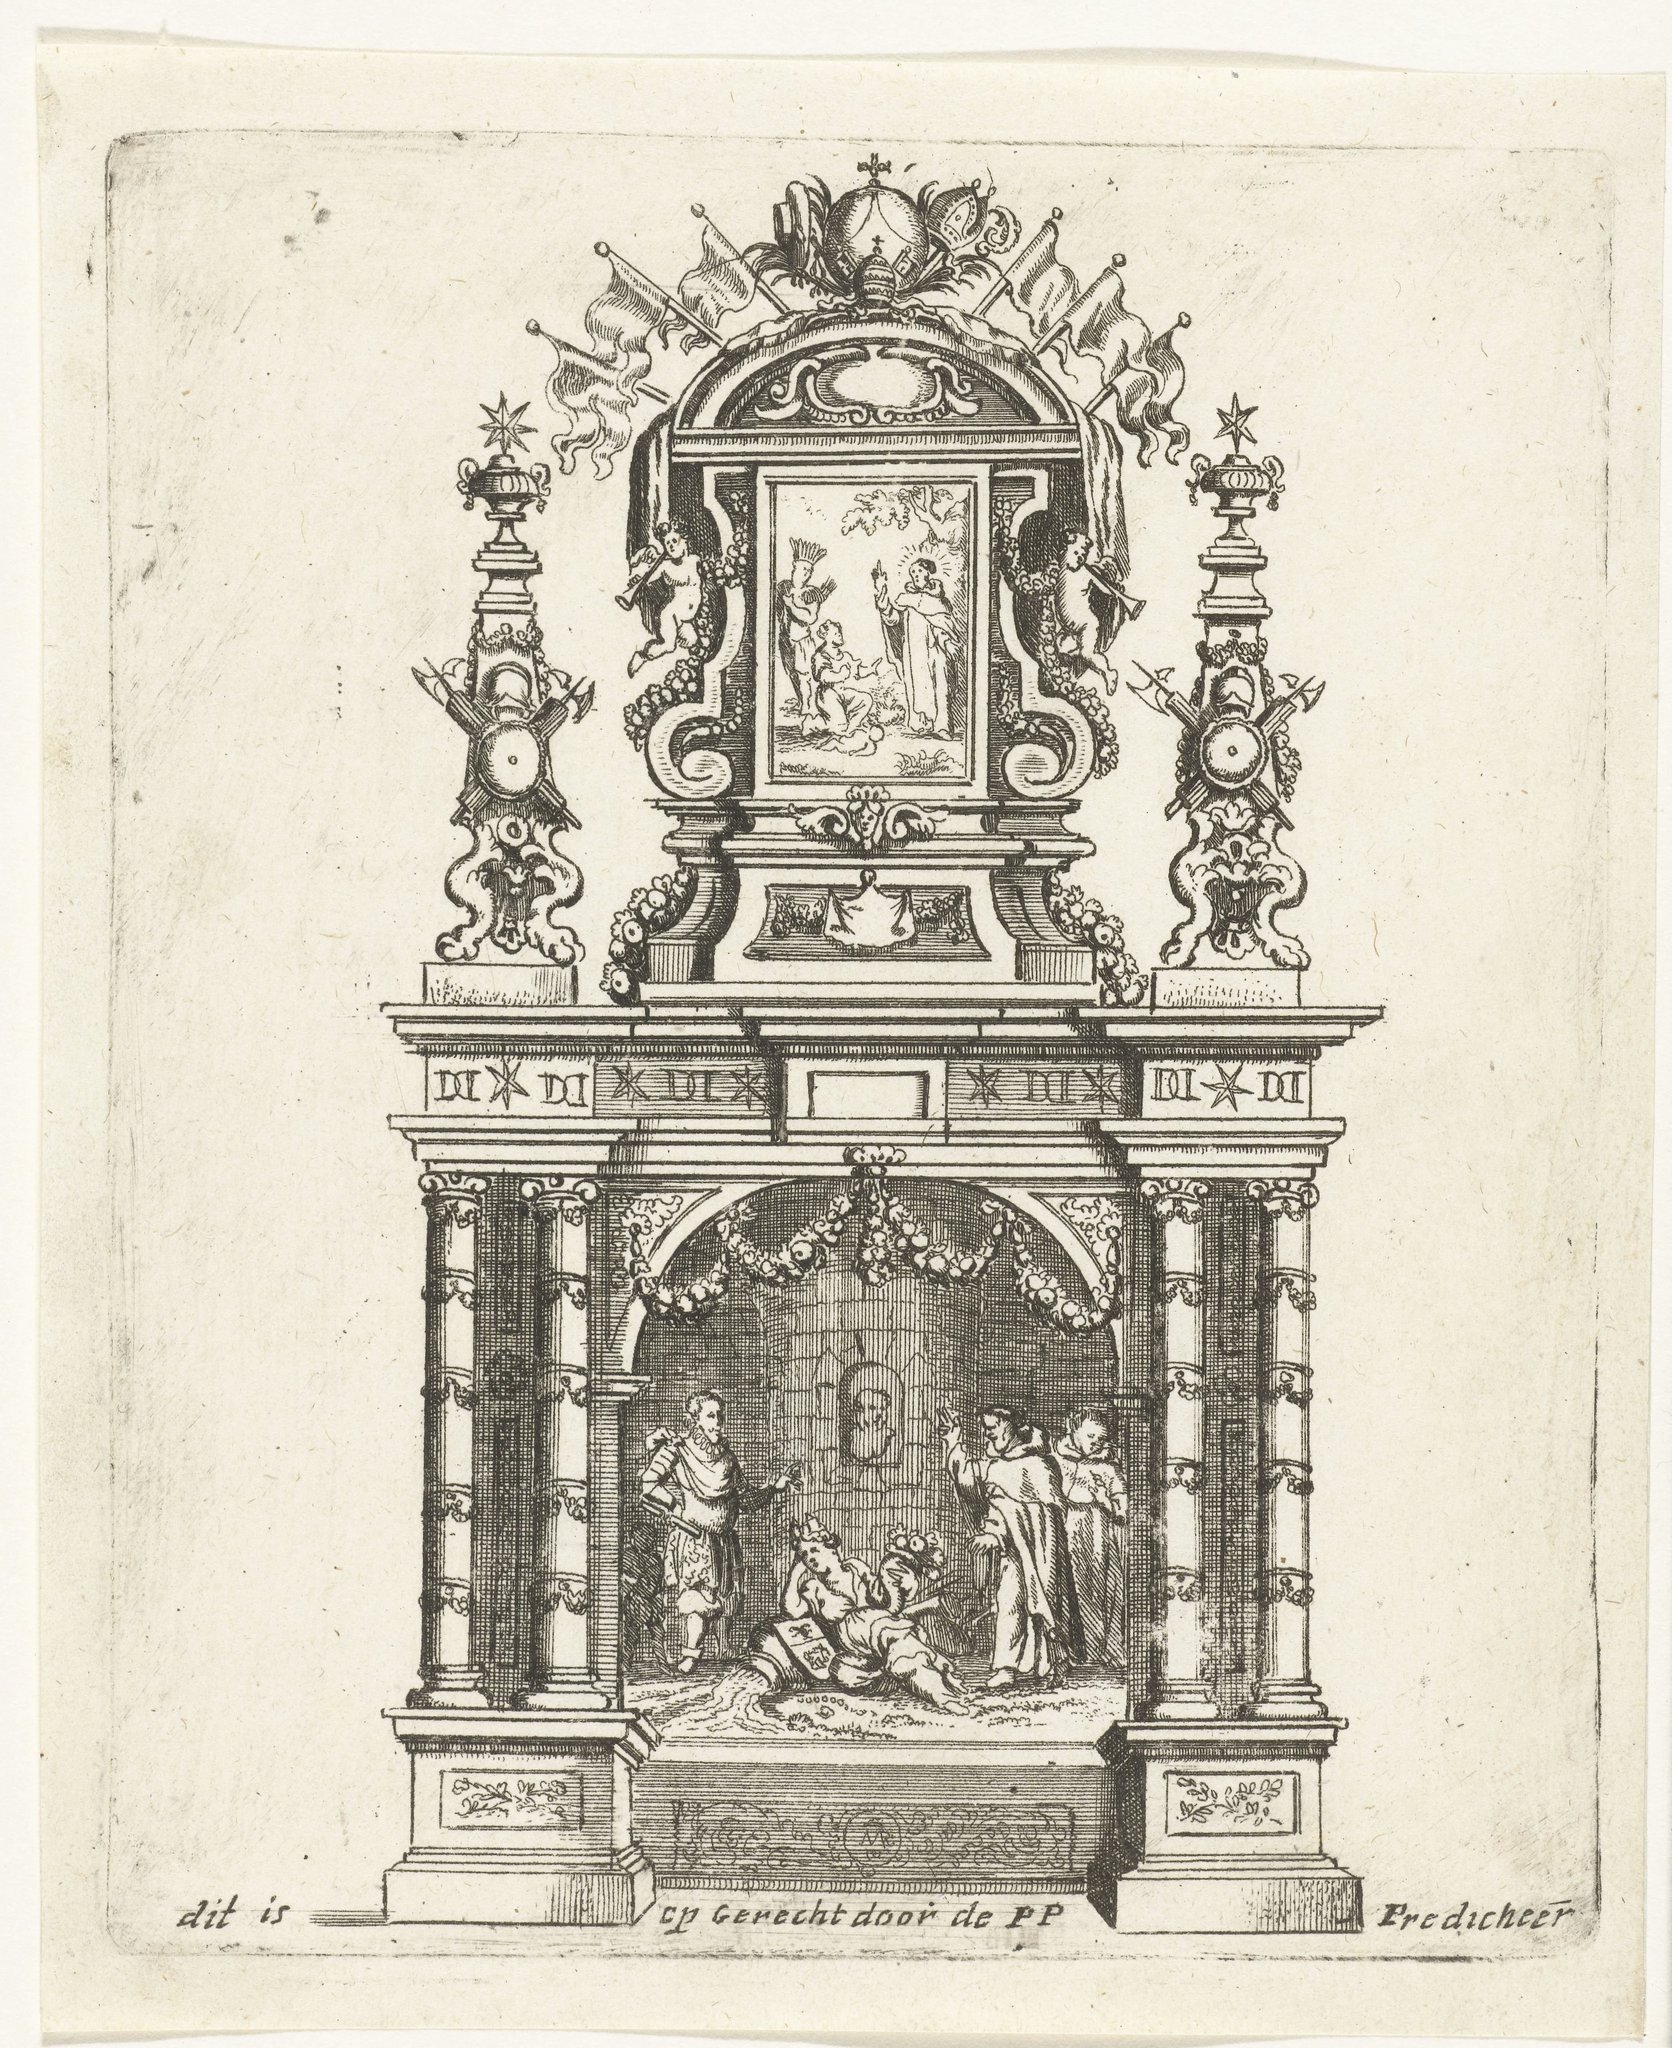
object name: print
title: Altaar opgericht door de predikheren, 1685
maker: gaspar bouttats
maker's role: print maker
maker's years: 1640-1695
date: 1685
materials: paper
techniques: etching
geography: southern netherlands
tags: other decorative structures (~ triumphal entry, etc.), antwerp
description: Gebruikt als illustratie in: Hondert-jaerigh jubile-vreught bewesen in dese stadt Antwerpen ter oorsaecke vande herstellinge des geloofs in't jaer 1585. door de glorieuse waepenen van sijne catholijcke majesteyt, onder t'beleyt van ... Alexander Farnesius ... / Ghemaeckt ende by-een vergadert door ... Petrus Franciscus de Smidt, Hieronymus Verdussen den jonghere, Antwerpen 1685.